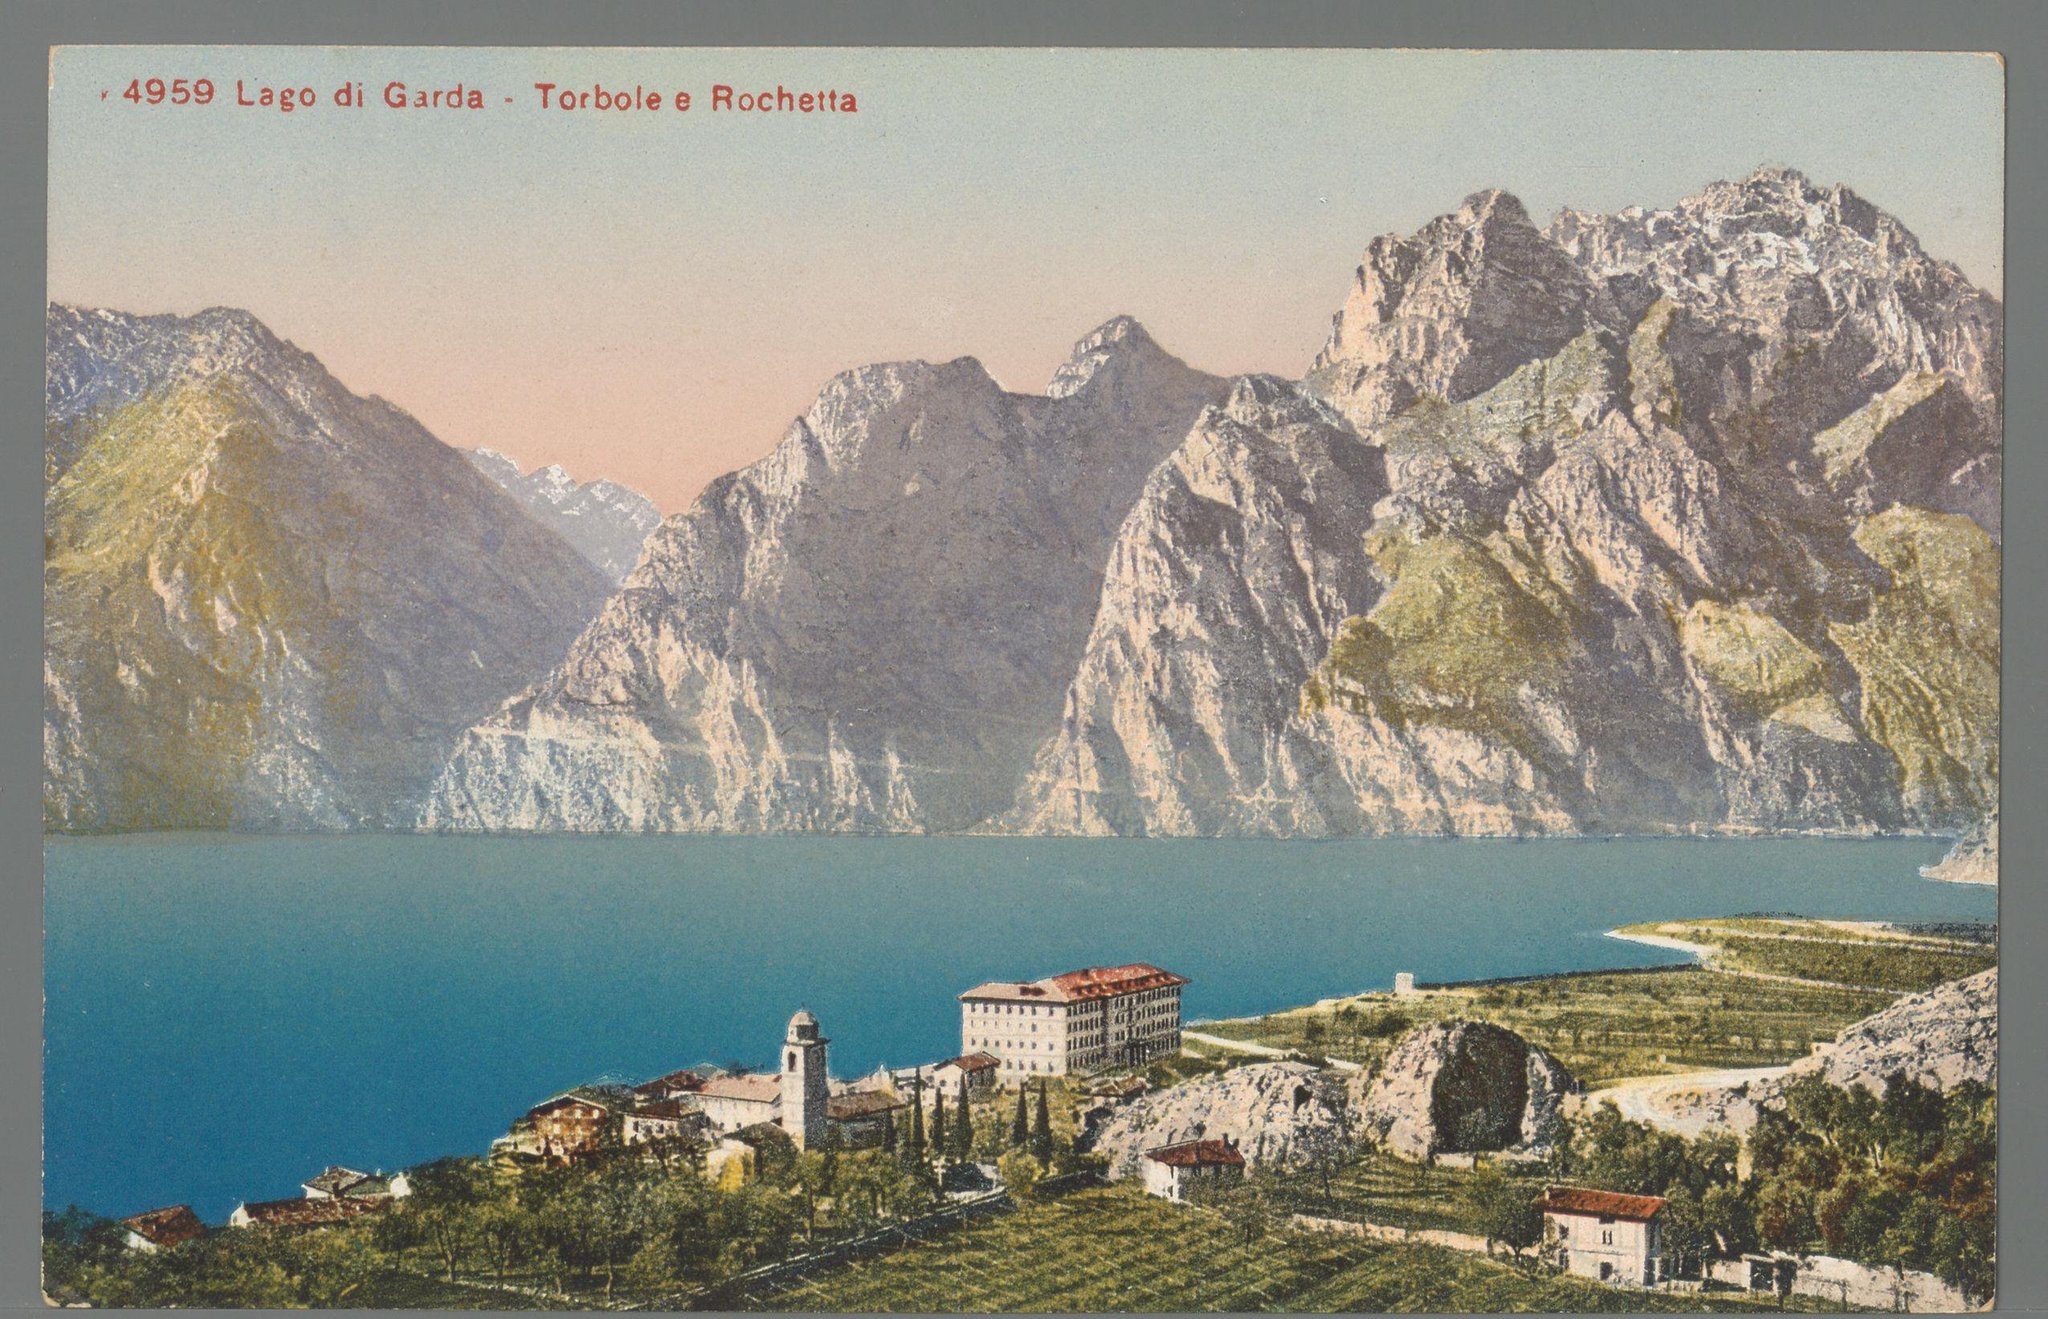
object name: photomechanical print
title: Lago di Garda. Torbole e Rochetta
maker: Anonymous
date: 1905-1930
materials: cardboard, photographic process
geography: torbole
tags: prospect of village, silhouette of village, lake, mountains